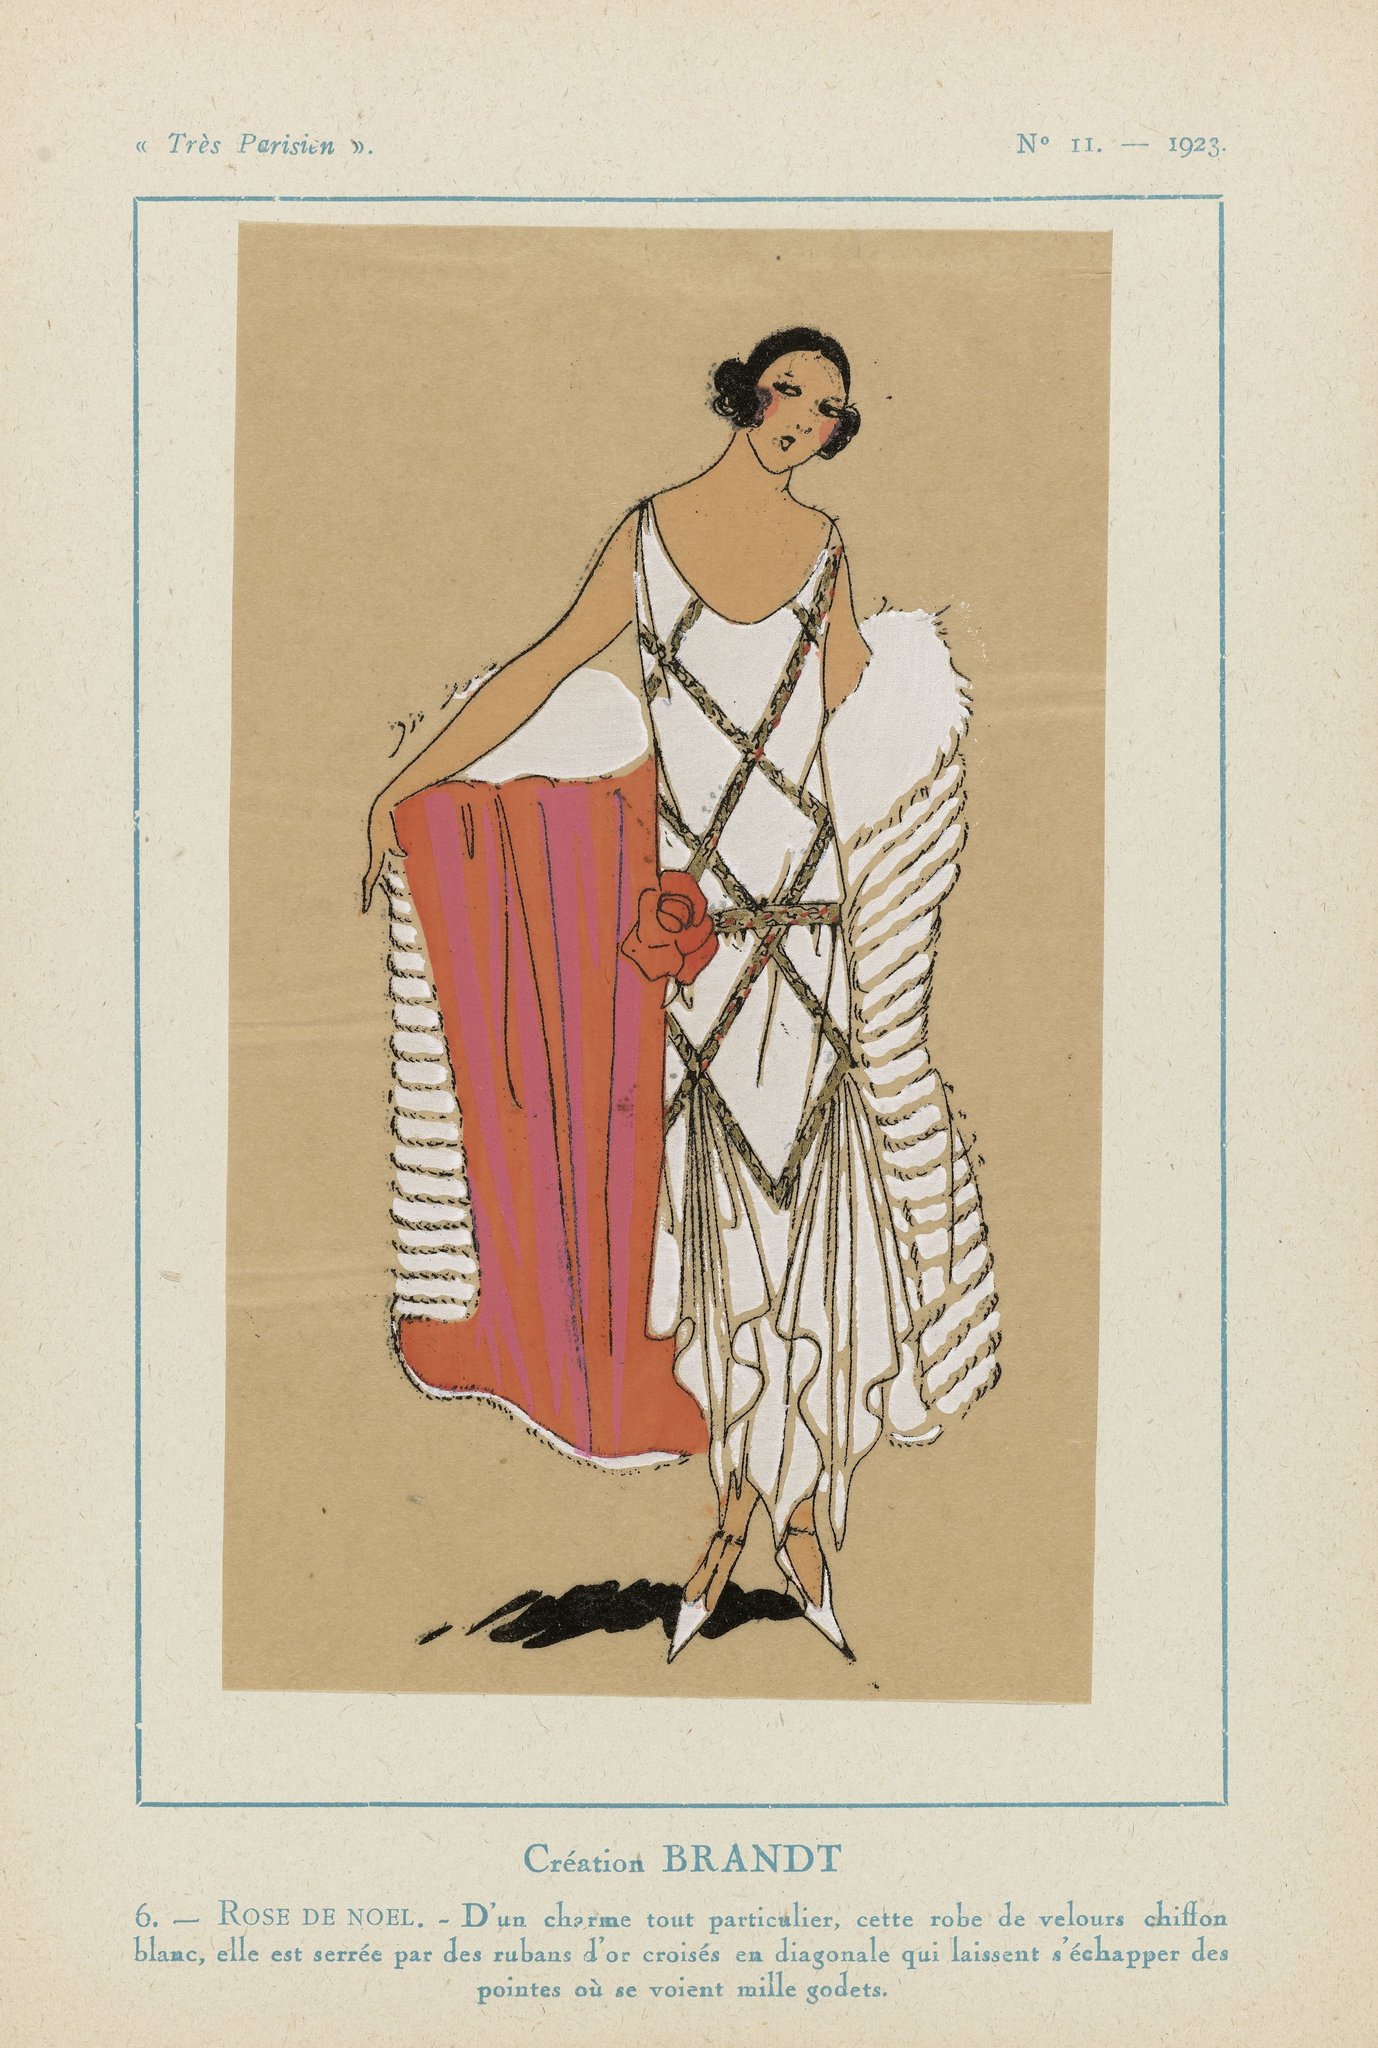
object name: fashion print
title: Très Parisien, 1923, No 11: 6.- ROSE DE NOEL. - D'un charme tout particulier...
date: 1923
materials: paper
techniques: hand coloring, letterpress printing, lithography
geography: paris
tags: corsage (+ women's clothes), border, ribbon, braid (+ women's clothes), cape (+ women's clothes), fashion plates, dress, gown (+ women's clothes)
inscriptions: caption: ‘Création BRANDT / 6. - ROSE DE NOEL. - D'un charme tout particulier, cette robe de velours chiffon blanc, elle est serrée par des rubans d'or croisés en diagonale qui laissent s'échapper des pointes où se voient mille godets.’, title: ‘Très Parisien / No 11. - 1923’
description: Ontwerp van Brandt. Jurk van witte 'velours chiffon' waarover goudkleurige linten, diagonaal gekruist, en aan de onderzijde 'mille godets' (valse plooien). Cape(?) van bont. Bloemcorsage. Prent uit het modetijdschrift Très Parisien (1920-1936).